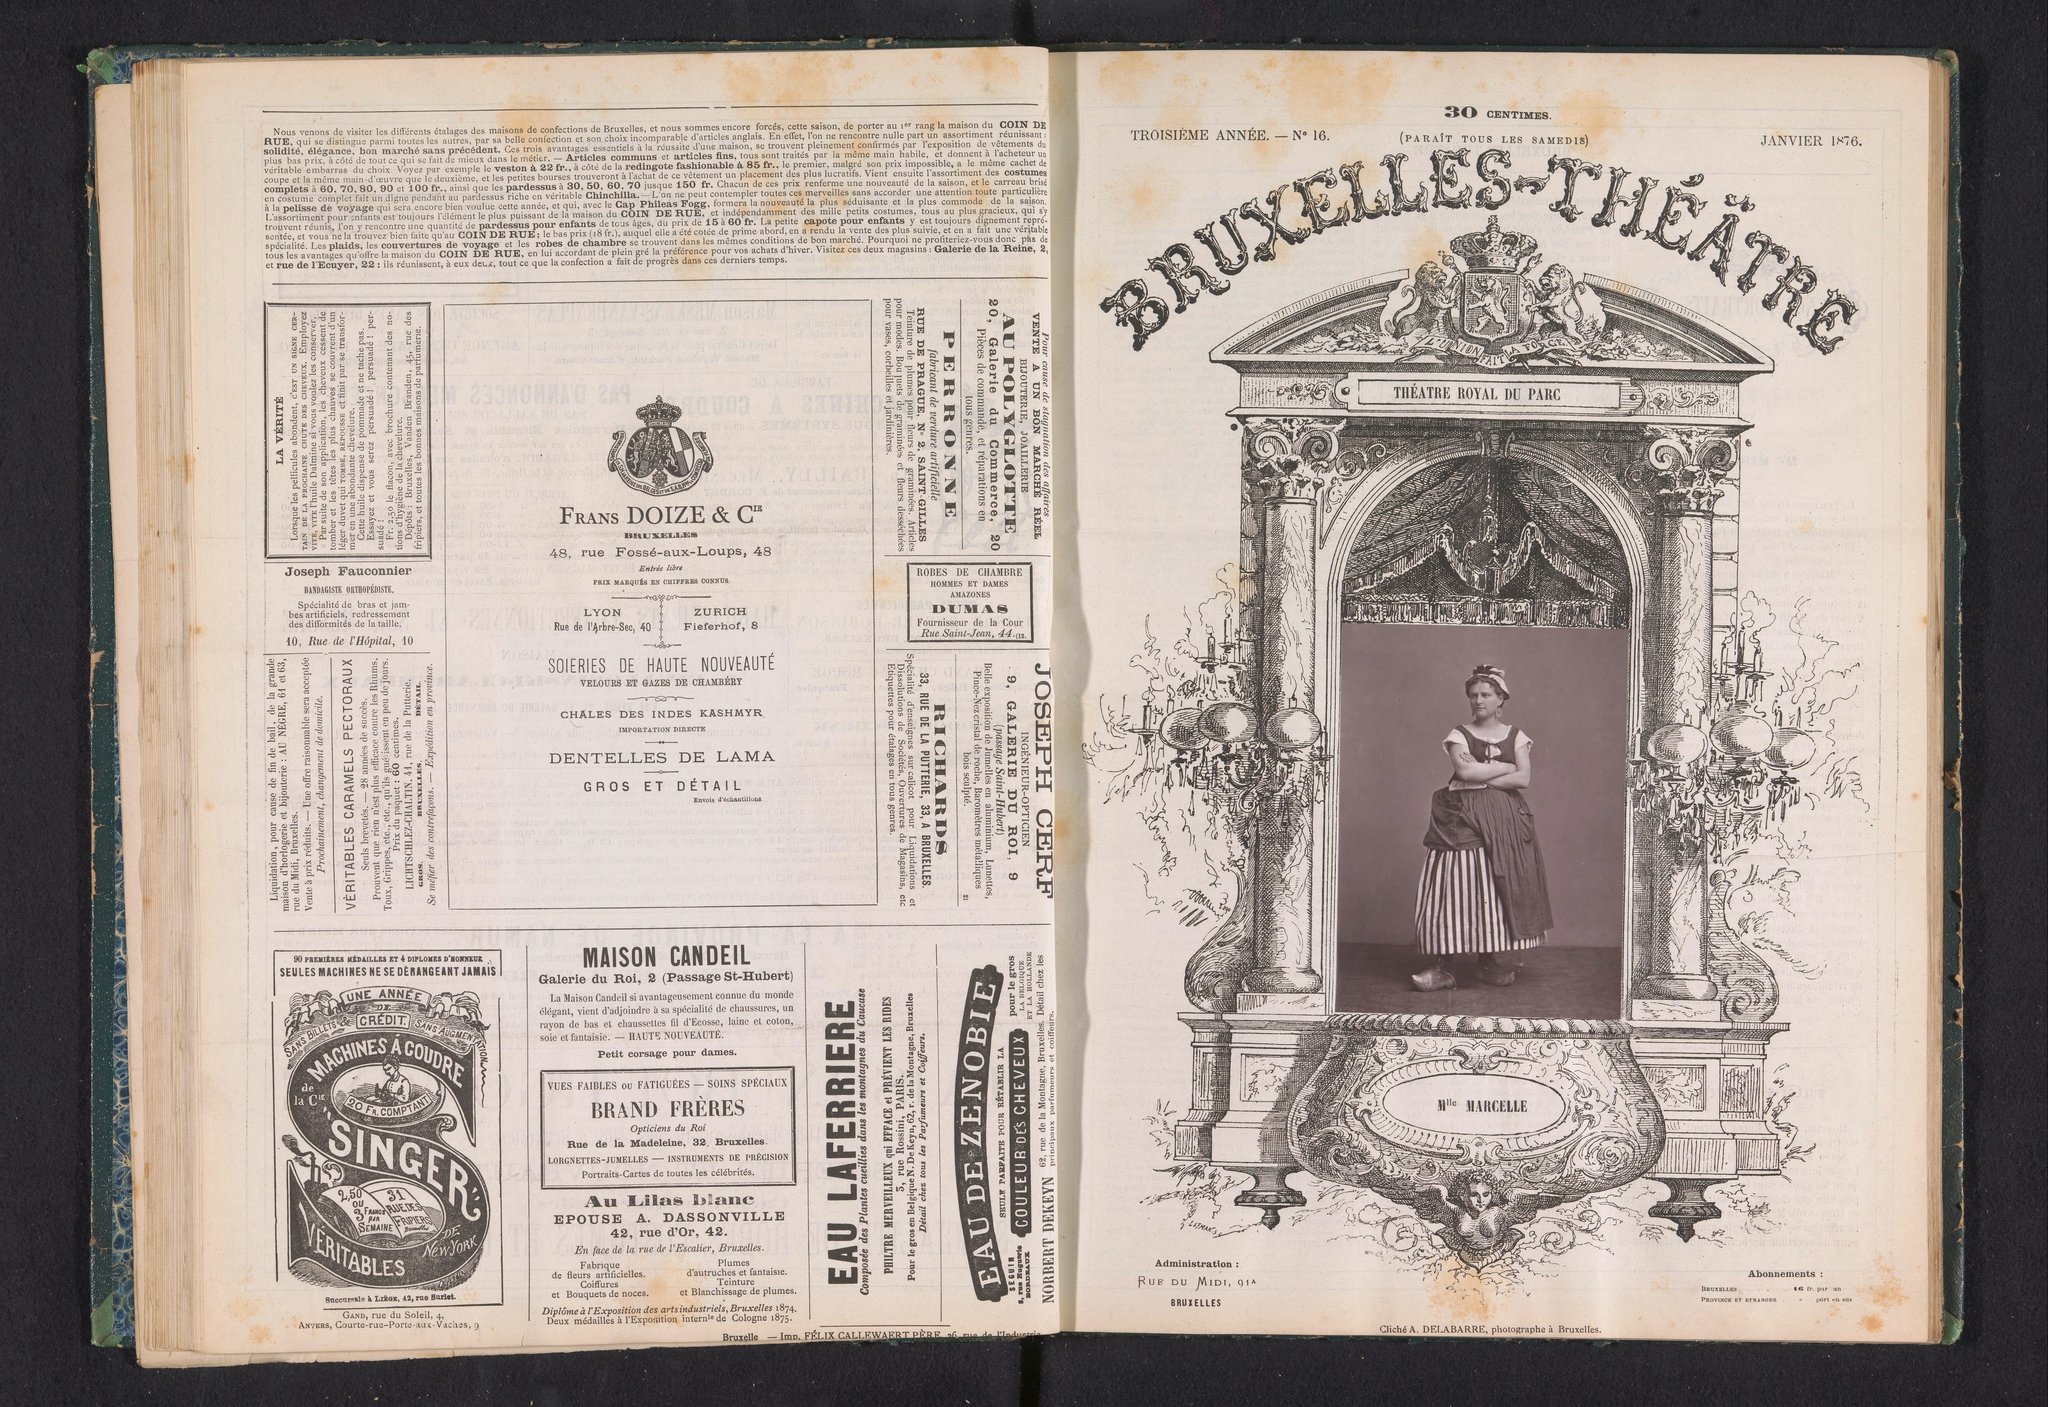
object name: page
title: Portret van mademoiselle Marcelle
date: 1871-1876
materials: paper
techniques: woodburytype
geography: brussels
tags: portrait of actor, actress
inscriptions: number: ‘No 16.’